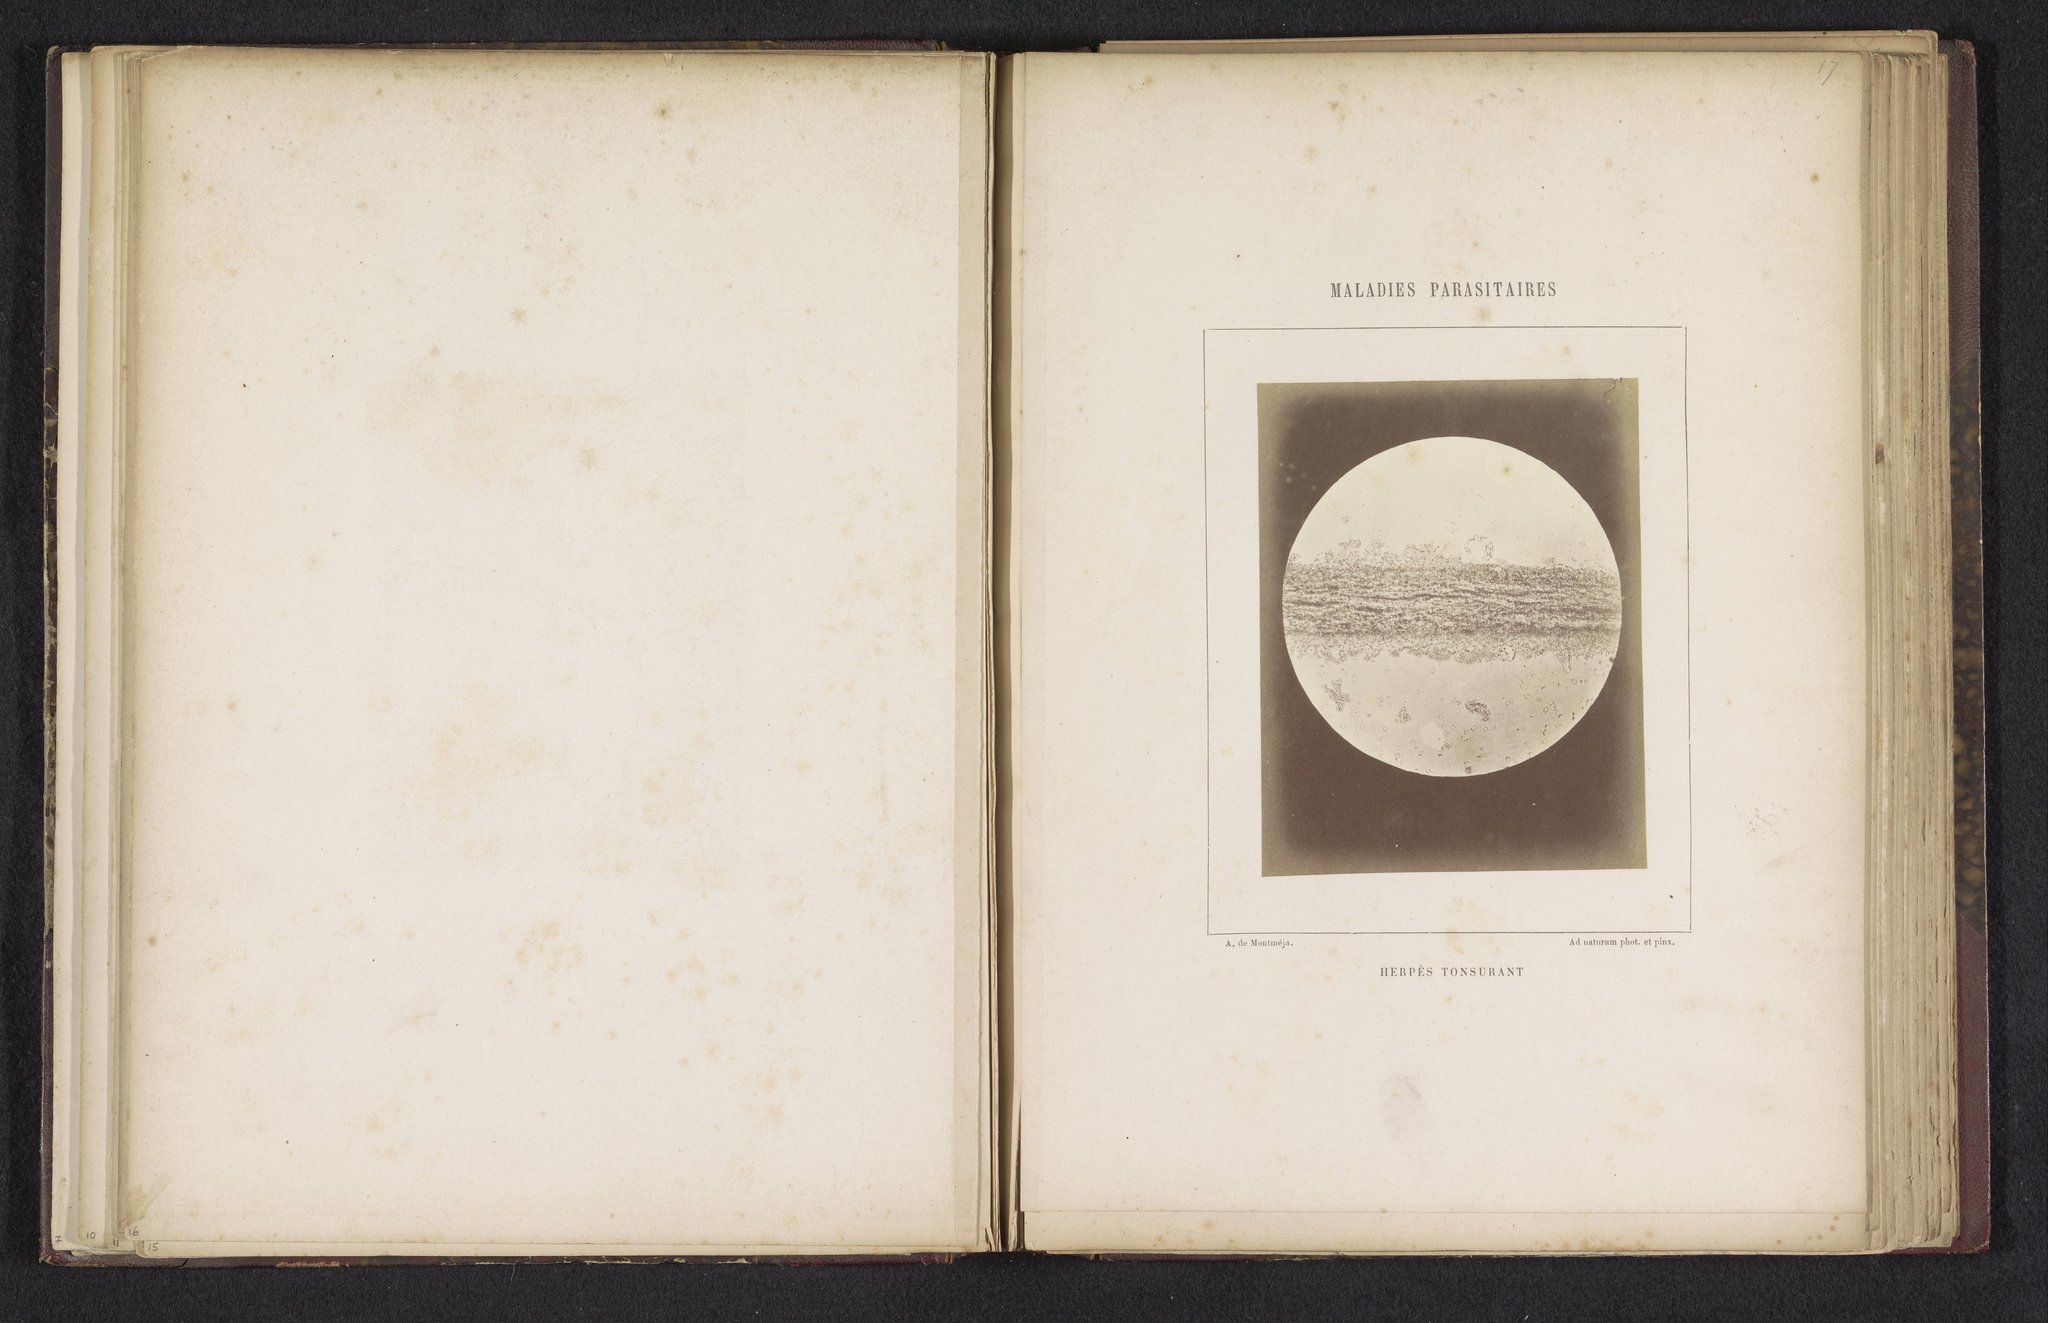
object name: page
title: Herpès tonsurant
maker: a. de montméja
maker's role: arts, fotograaf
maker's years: 1841-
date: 1860-1868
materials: photographic support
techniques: albumen print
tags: skin and venereal diseases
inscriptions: inscription: ‘Maladies parasitaires’, number: ‘17’, inscription: ‘Ad naturam phot. et pinx.’